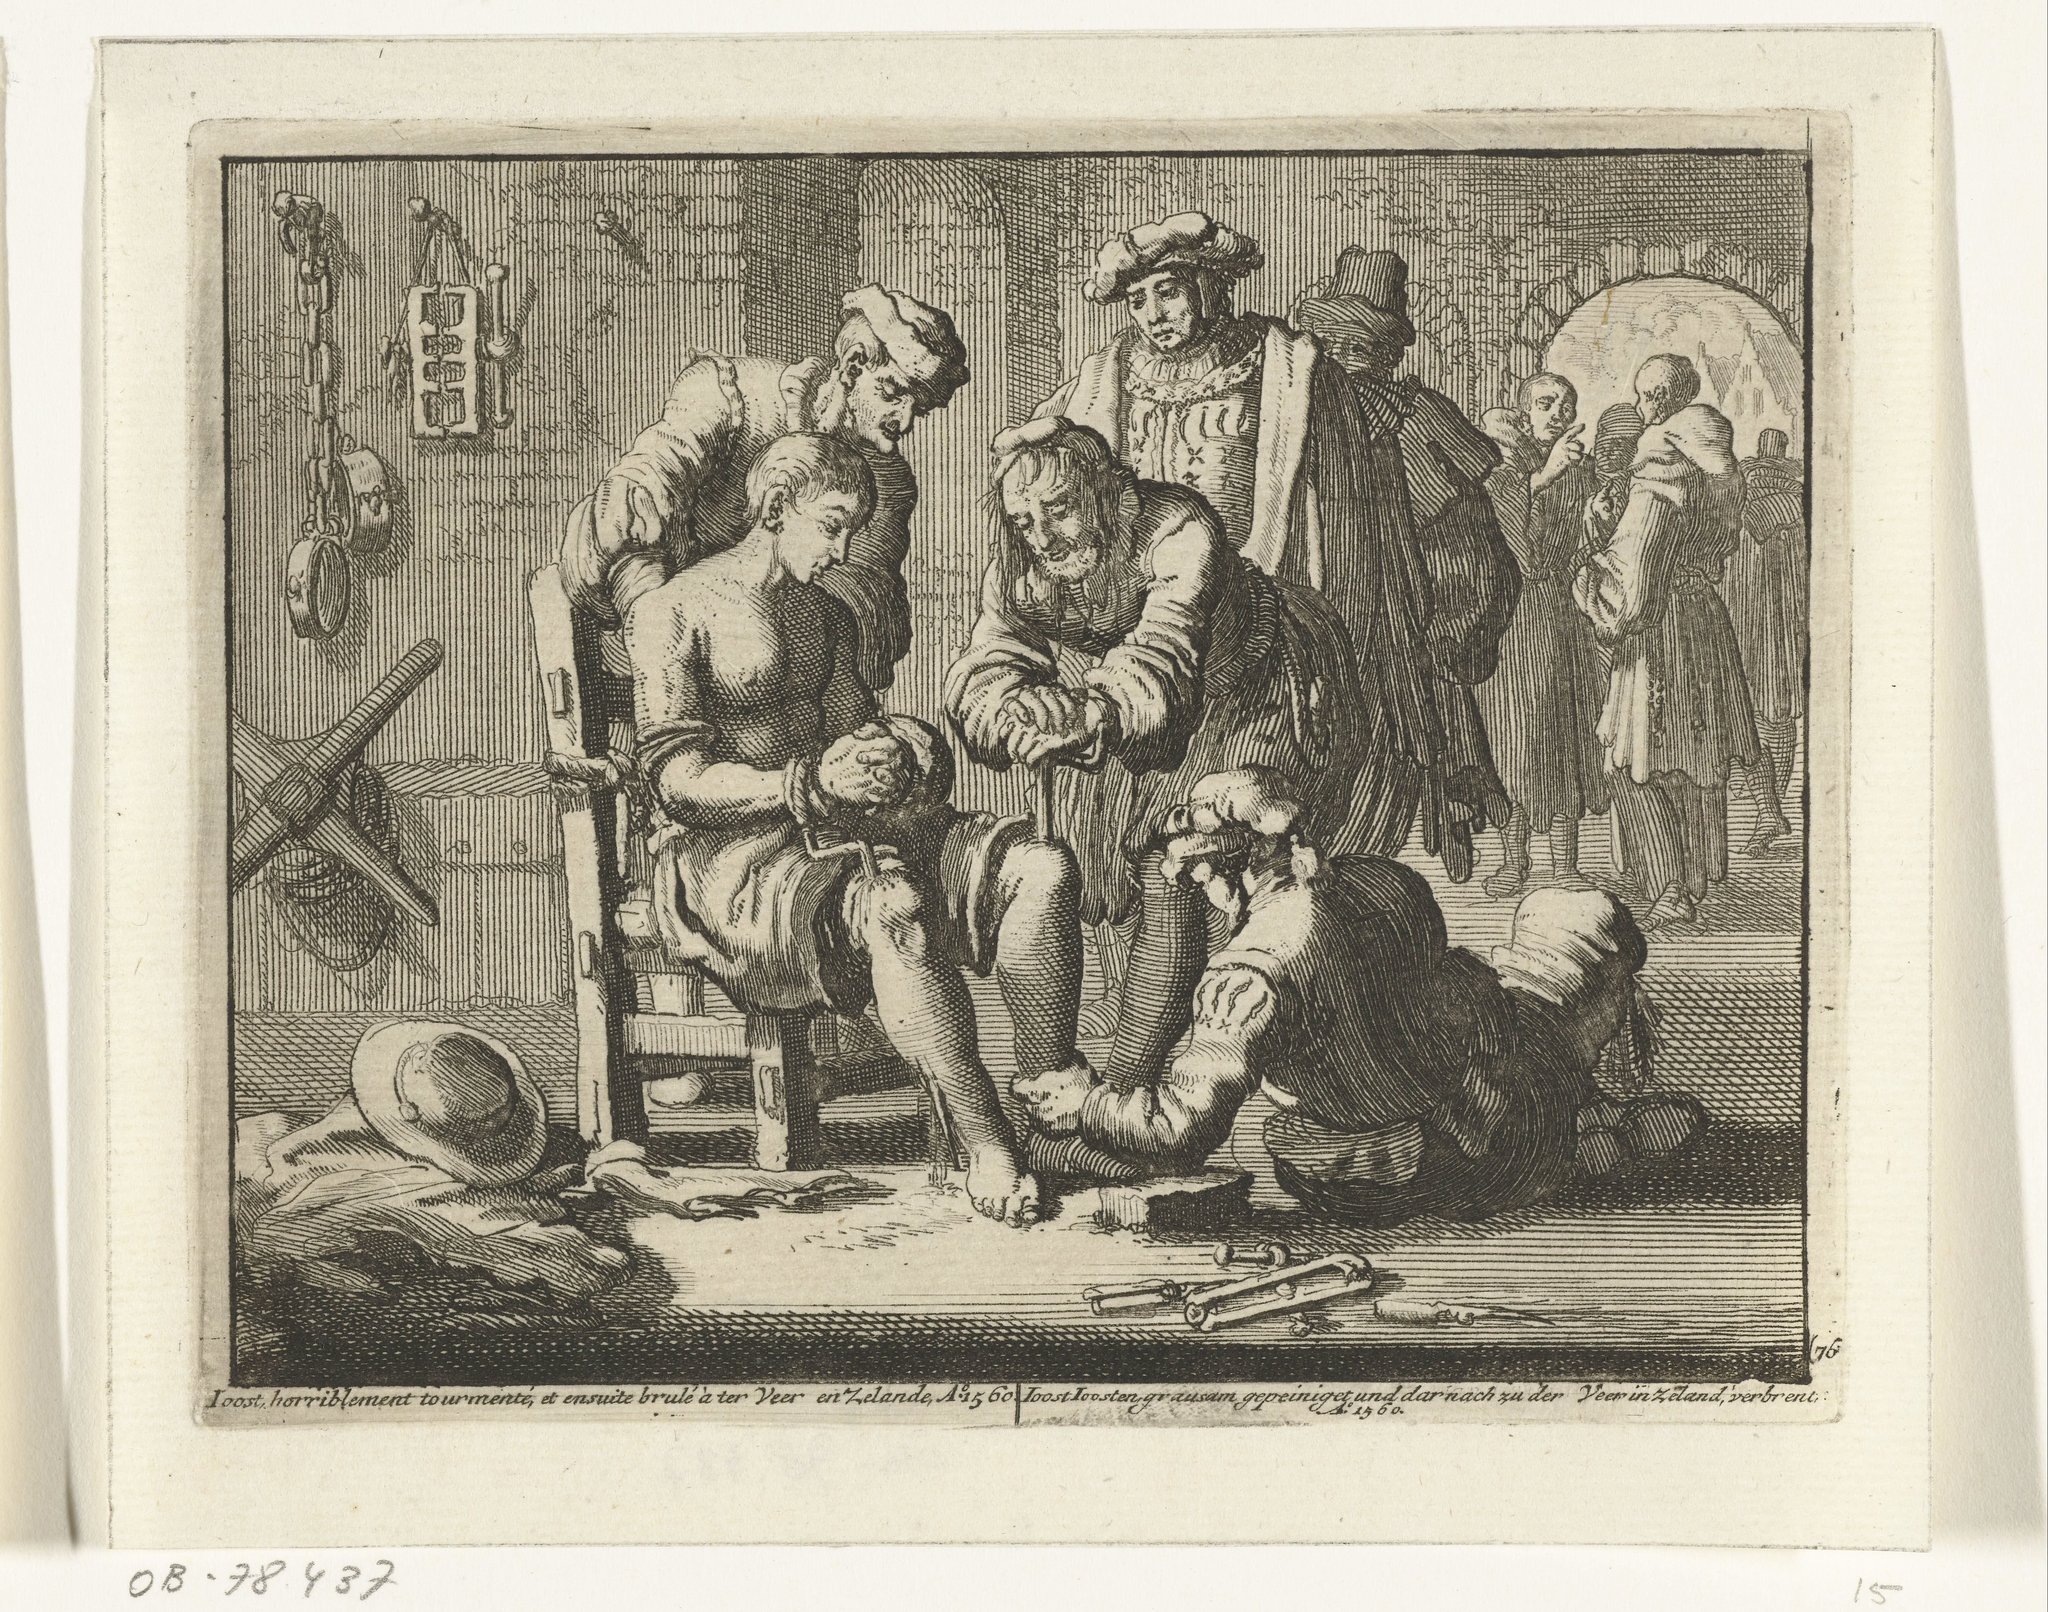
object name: print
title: Joost Joosten te Veere in de gevangenis gepijnigd, 1560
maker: jan luyken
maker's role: draughtsman, print maker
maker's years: 1649-1712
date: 1683-1685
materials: paper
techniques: etching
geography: northern netherlands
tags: execution of heretic, e.g. by burning at the stake, 'auto-da-fé'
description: De prenten in deze tweede staat gebruikt als illustratie voor: Theatre des martyrs, depuis la mort de J. Christ jusqu'à present (...). = Schau-buhne der Martyrer, P. van der Aa, Leiden ca. 1715, nr. 76. De prenten zijn oorspronkelijk vervaardigd voor en eerst gebruikt in: T.J. van Bragt, Het bloedig tooneel, of Martelaers spiegel der doops-gesinde of weereloose christenen, 1685.